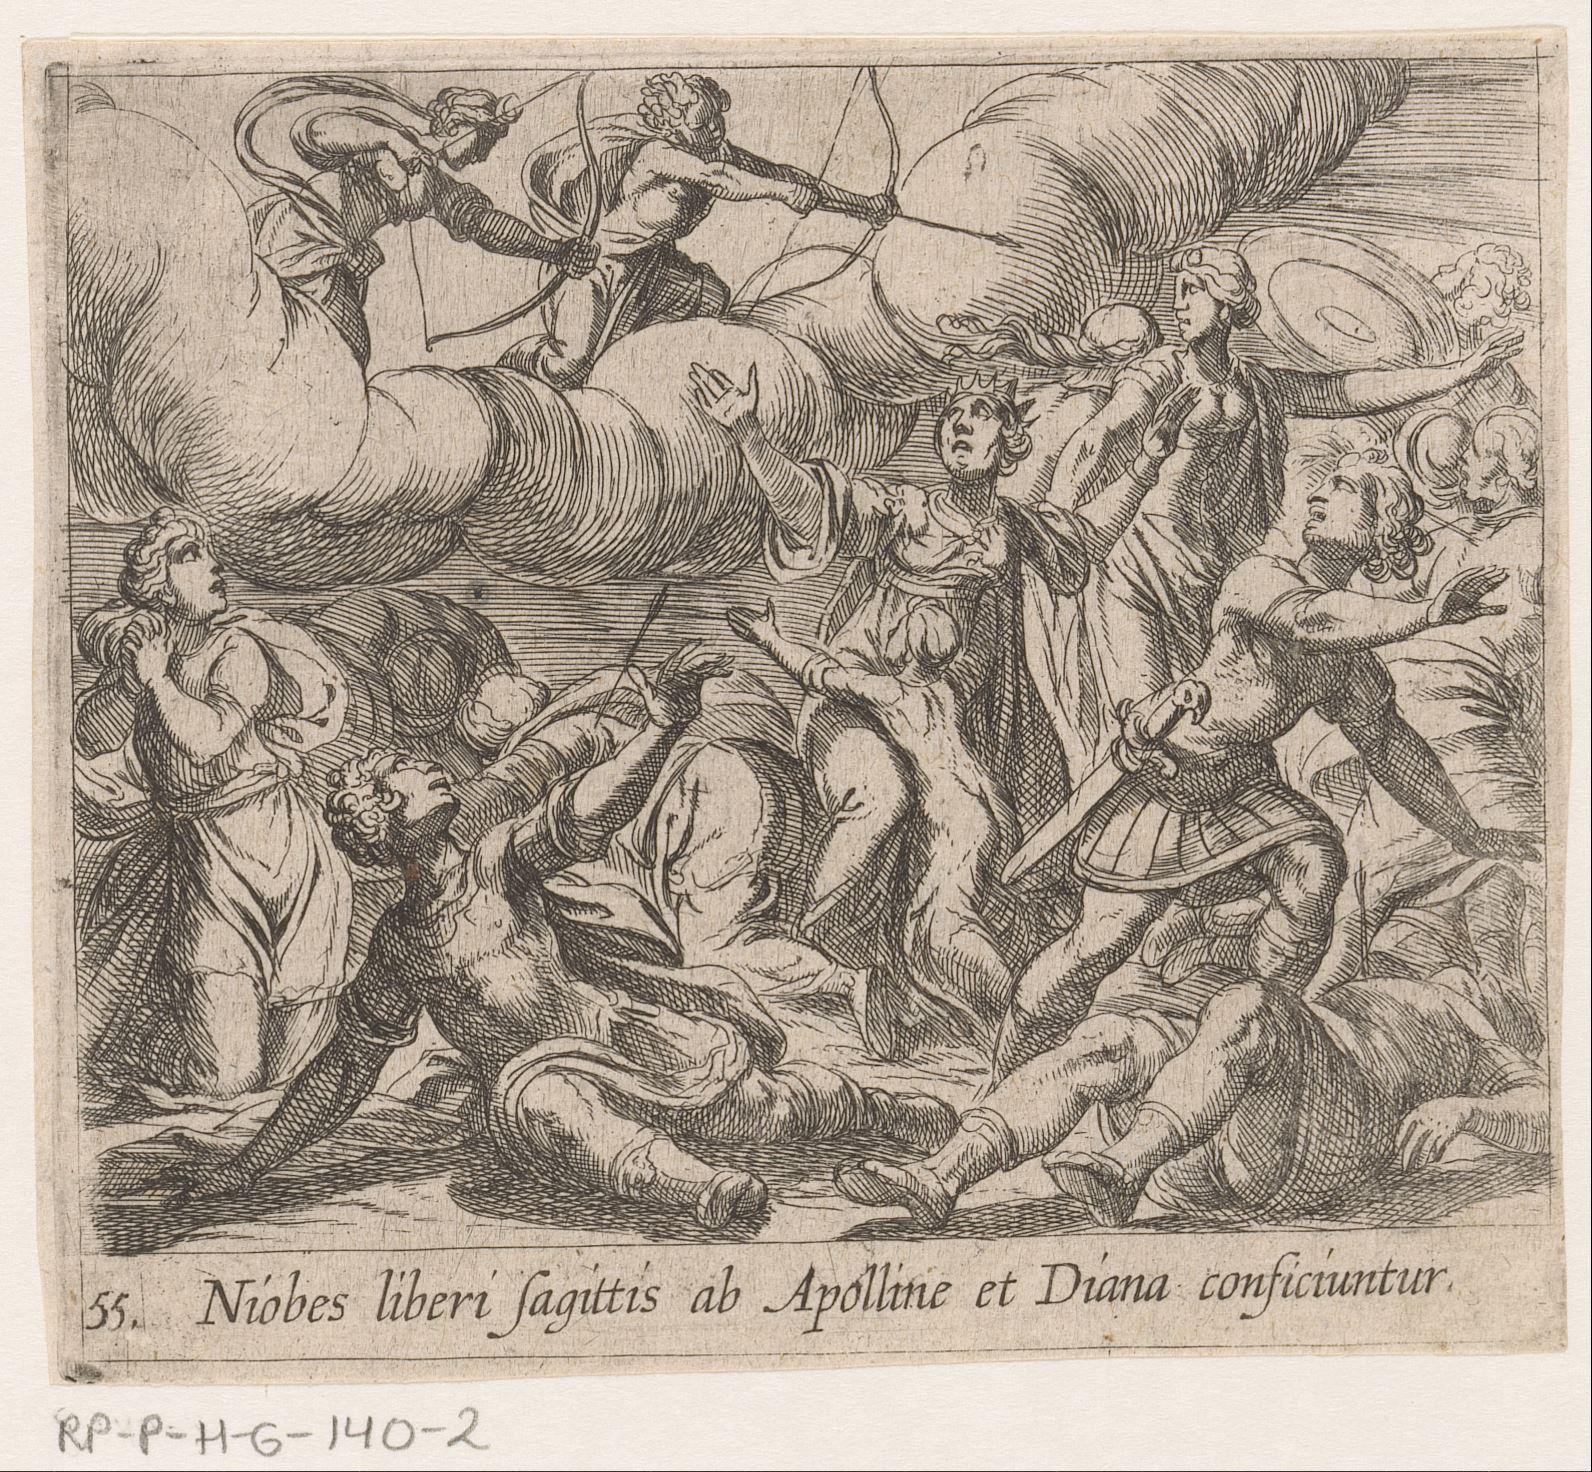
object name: print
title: Niobes liberi sagittis ab Apolline et Diana conficiuntur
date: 1606-1638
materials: paper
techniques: etching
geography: amsterdam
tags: apollo and diana kill niobe's children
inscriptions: collector's mark: ‘Hinloopen’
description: Apollo en Diana, beiden met pijl-en-boog, doden de kinderen van Niobe. Verschillende kinderen liggen dood op de grond, anderen proberen te vluchten. Titel in het Latijn in ondermarge.